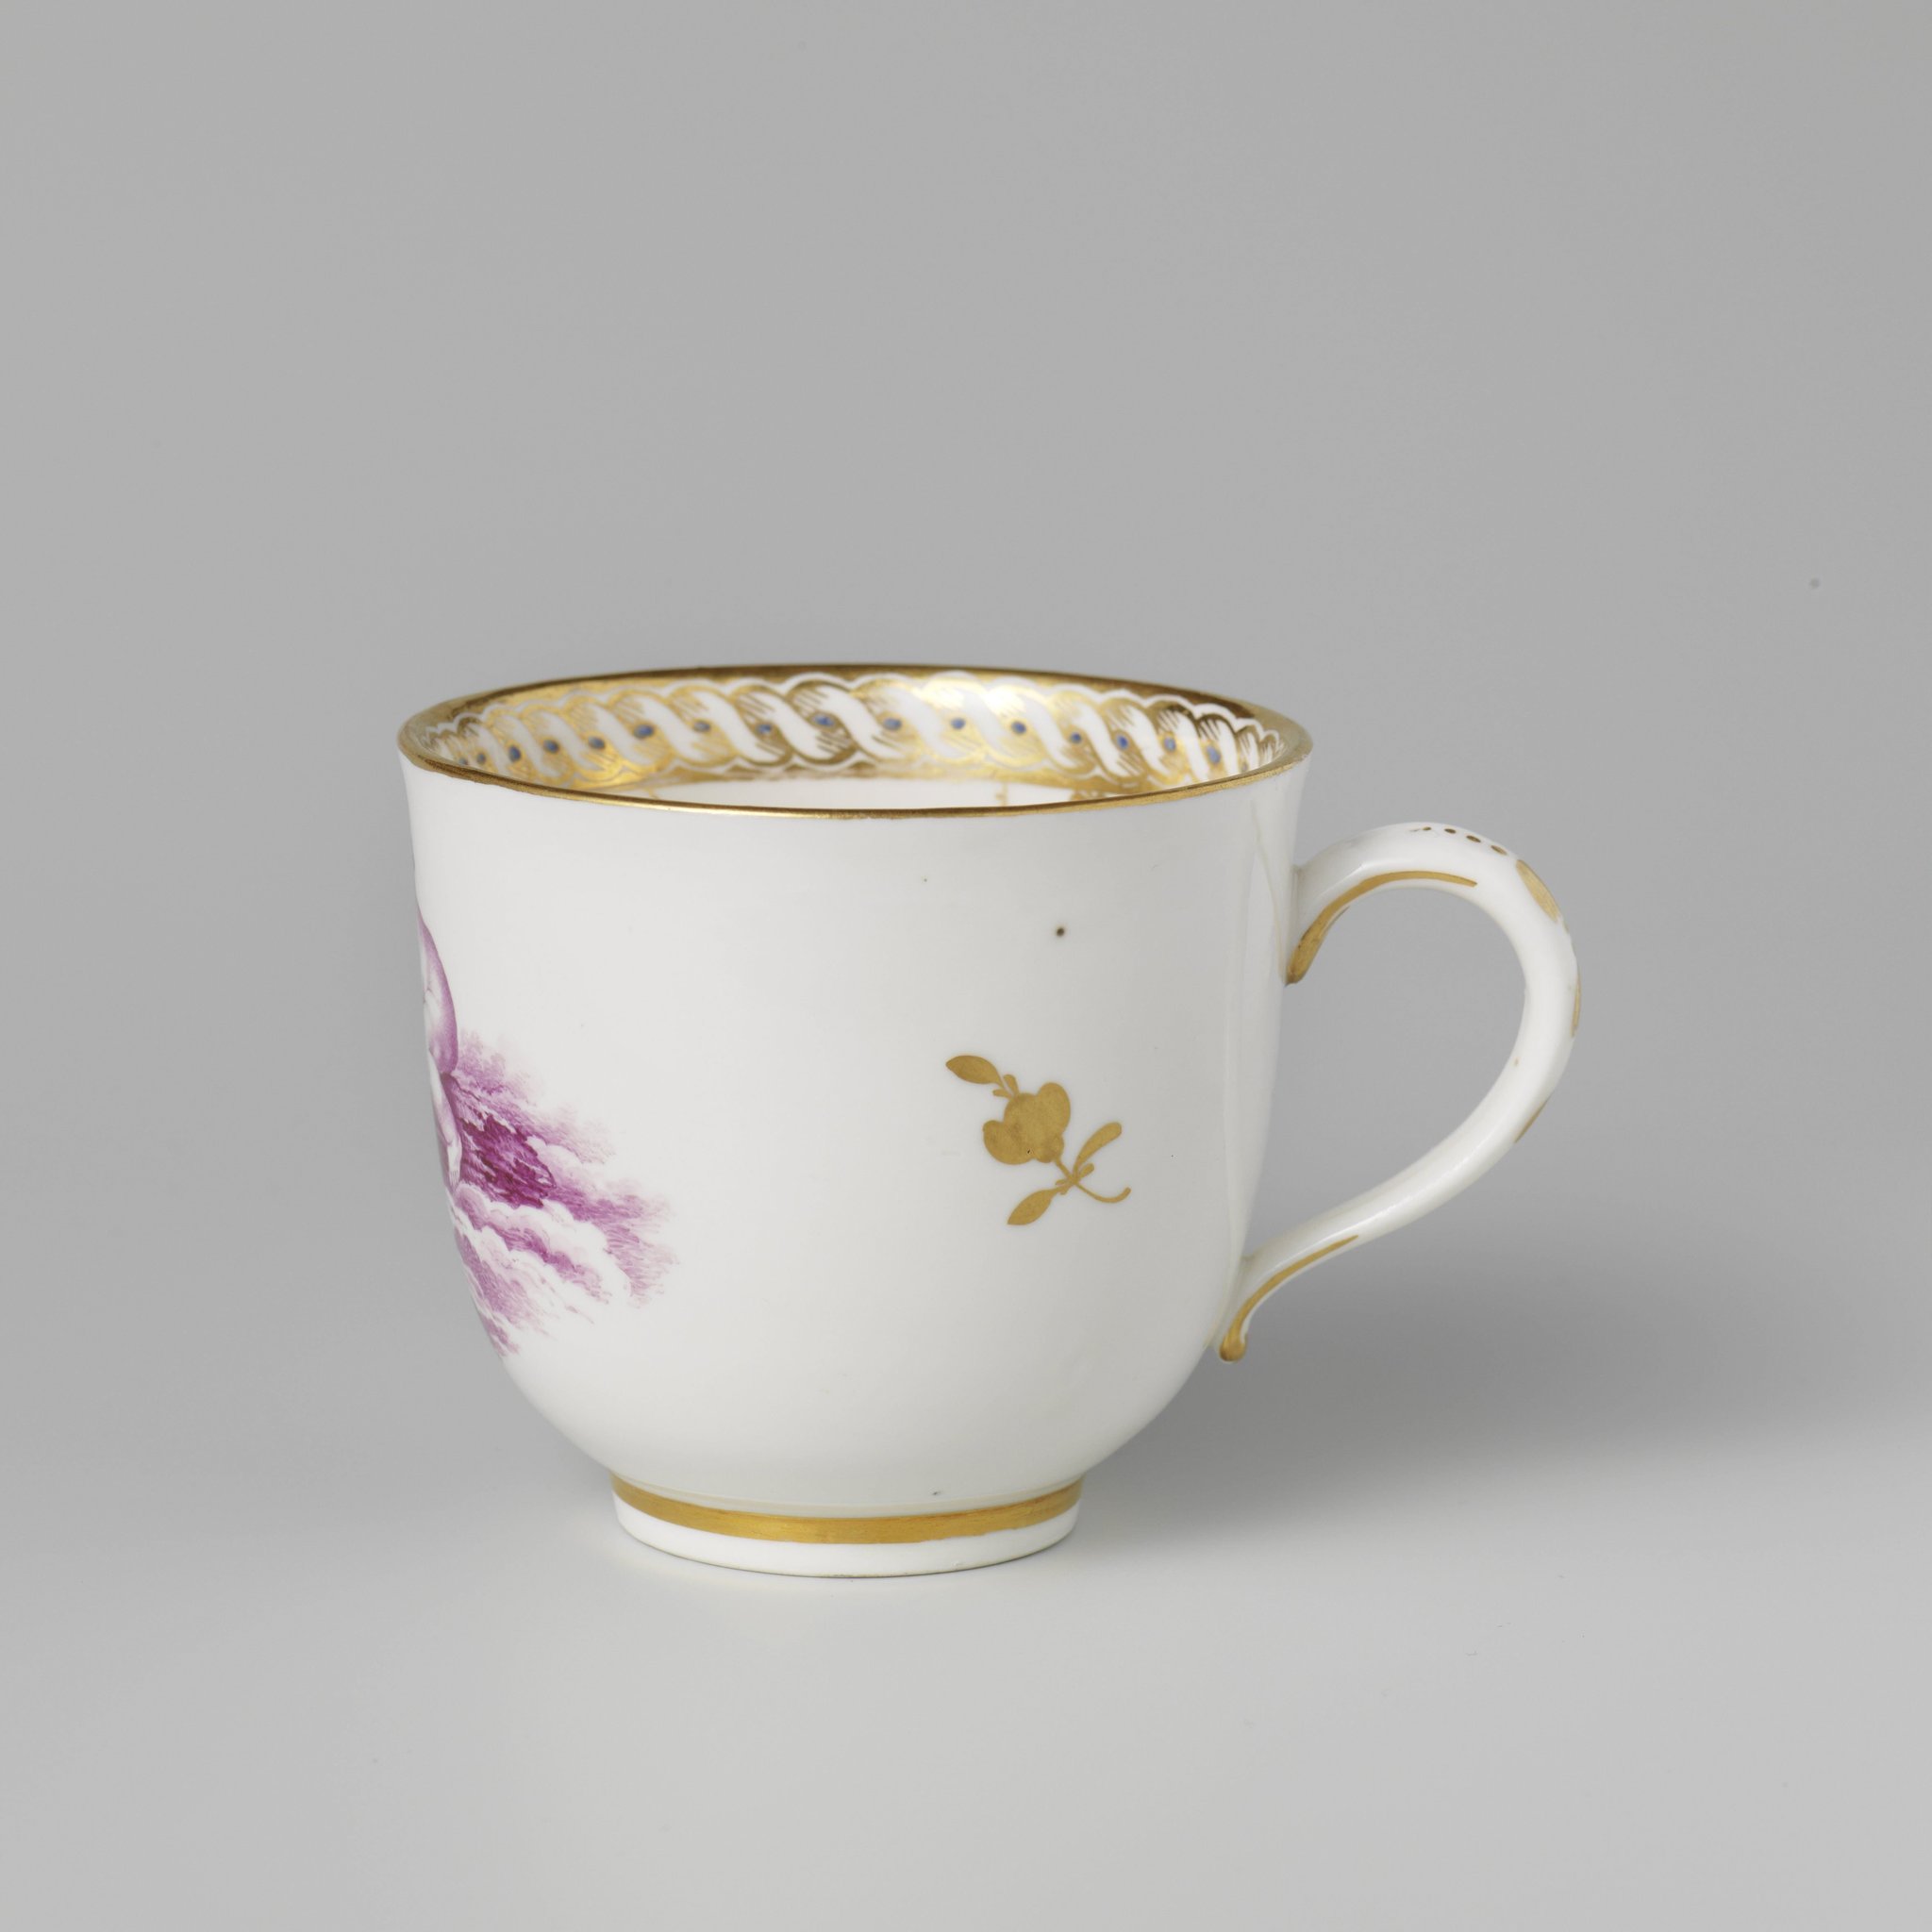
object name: service set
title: Cup with a putto on clouds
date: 1785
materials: glaze, gold, paint, porcelain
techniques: firing, forming, gilding, turning, vitrification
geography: germany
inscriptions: mark: ‘ooievaar’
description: Kop (koffiekop) van porselein met een C-vormig oor, beschilderd op het glazuur in roze (camaïeu) en goud. Op de buitenwand een putto zittend op een tak op een wolk. Om de voorstelling strooibloemen in goud. De binnenrand met een gedraaide band, waaraan guirlandes en bloemtakken hangen. Gouden lijn op de voet en gouden rand. Gemerkt op de onderzijde met de ooievaar.